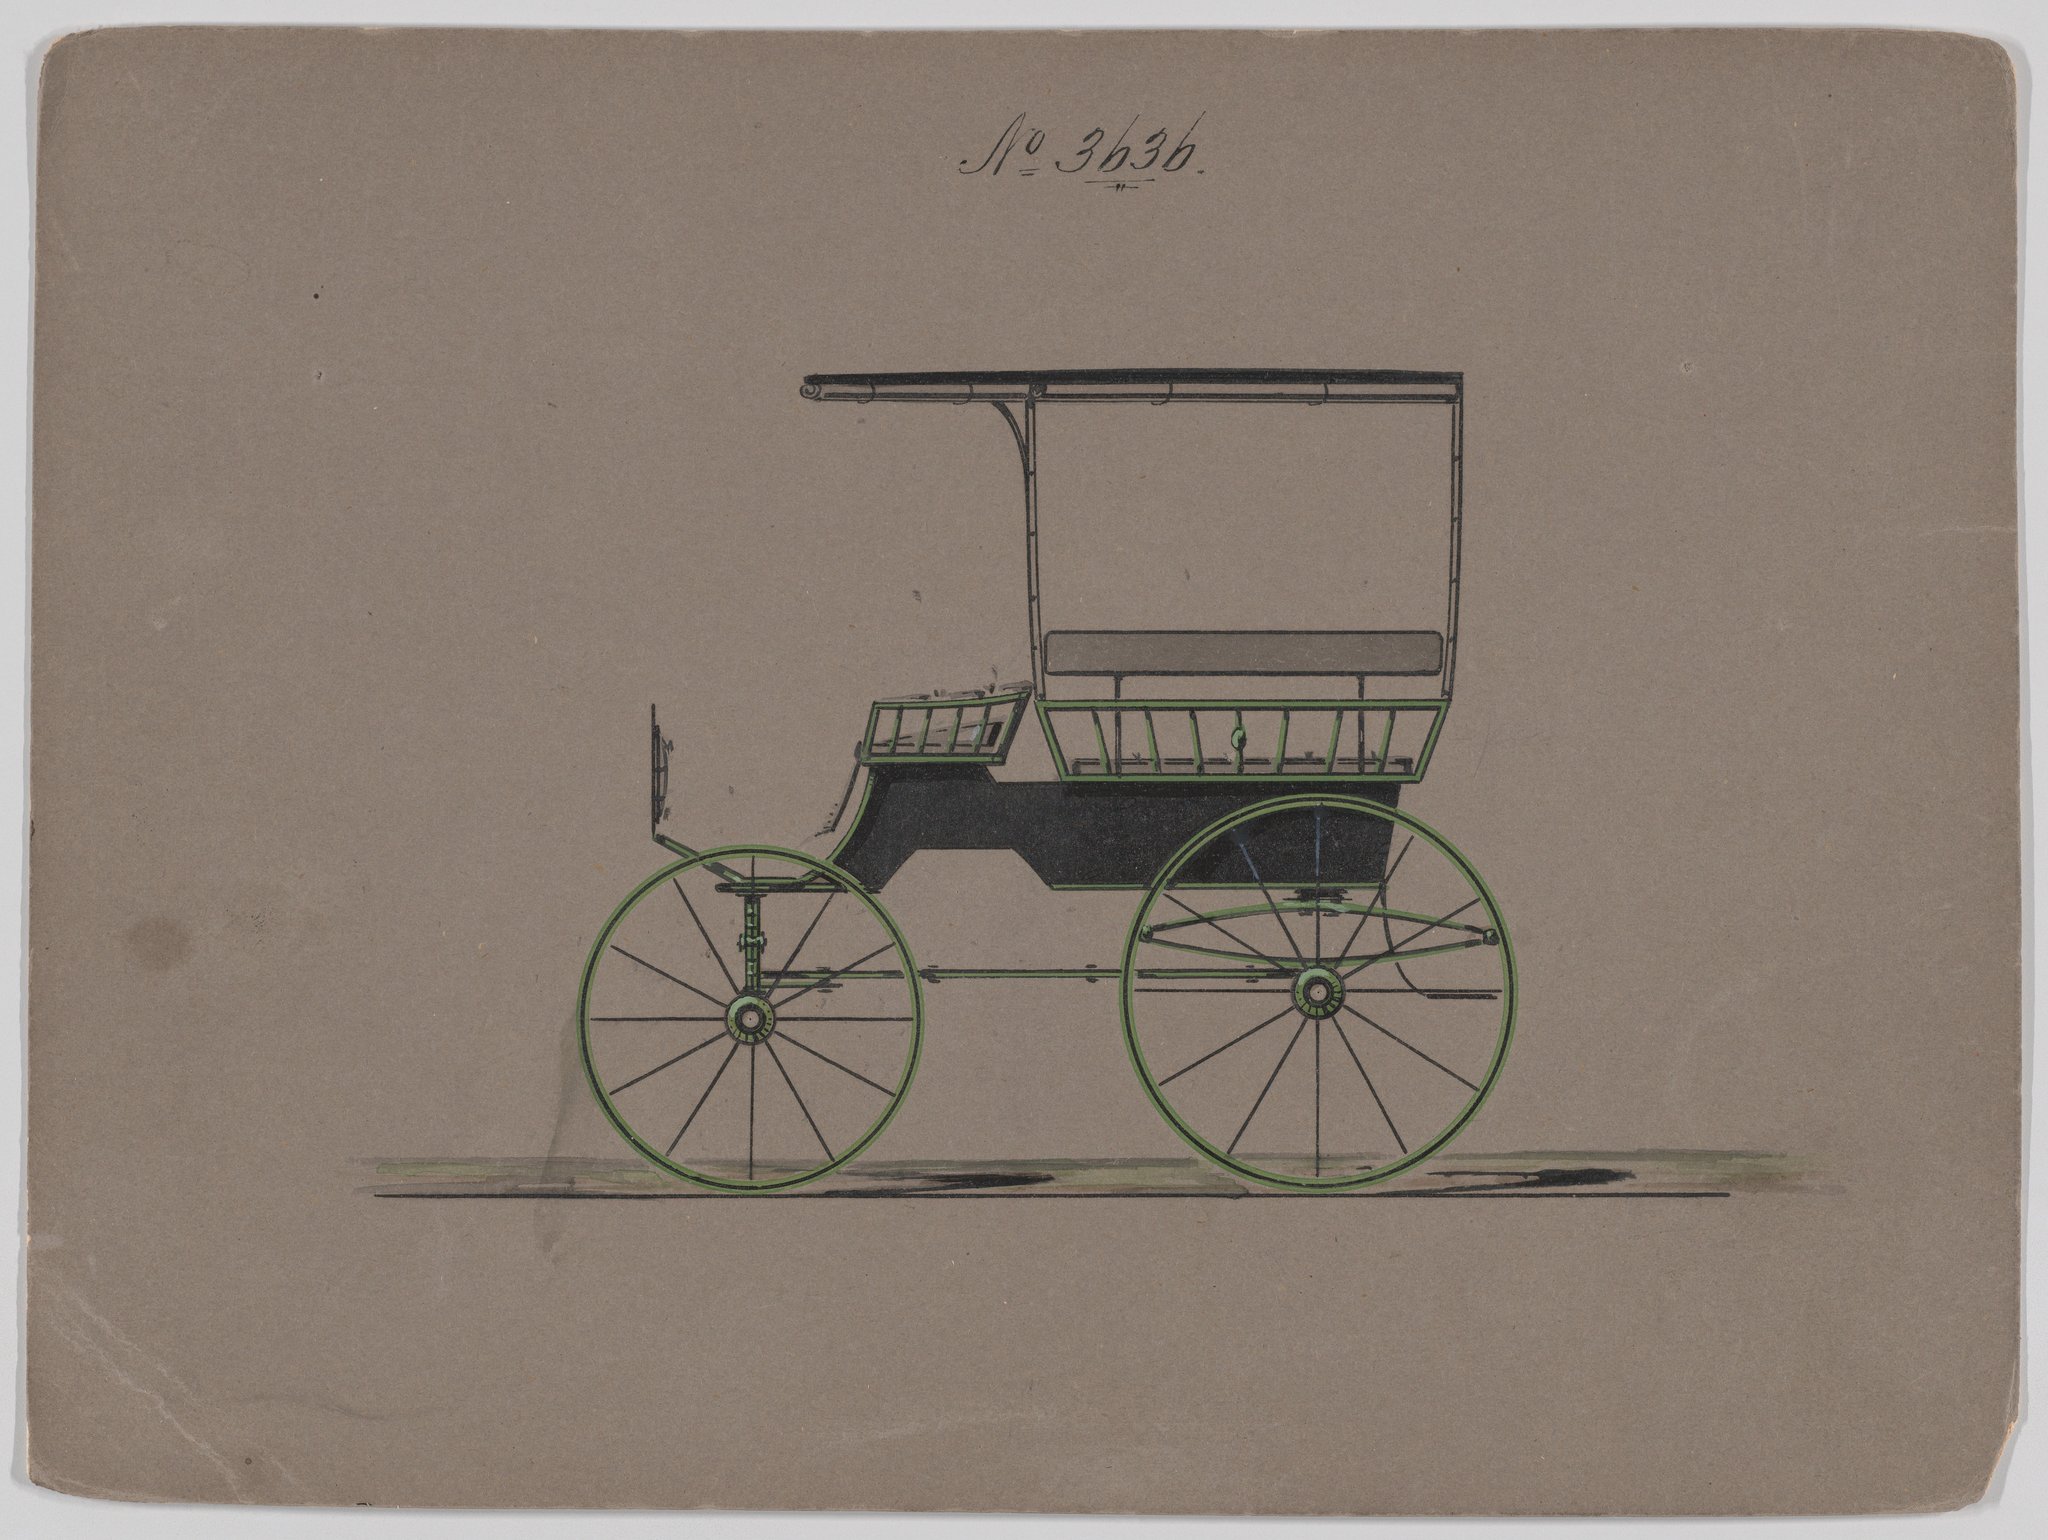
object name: drawing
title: Design for Omnibus or Wagonette, no. 3636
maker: brewster & co.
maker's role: manufacturer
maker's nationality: american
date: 1880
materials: gouache, gum arabic, ink, watercolor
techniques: pen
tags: carriages